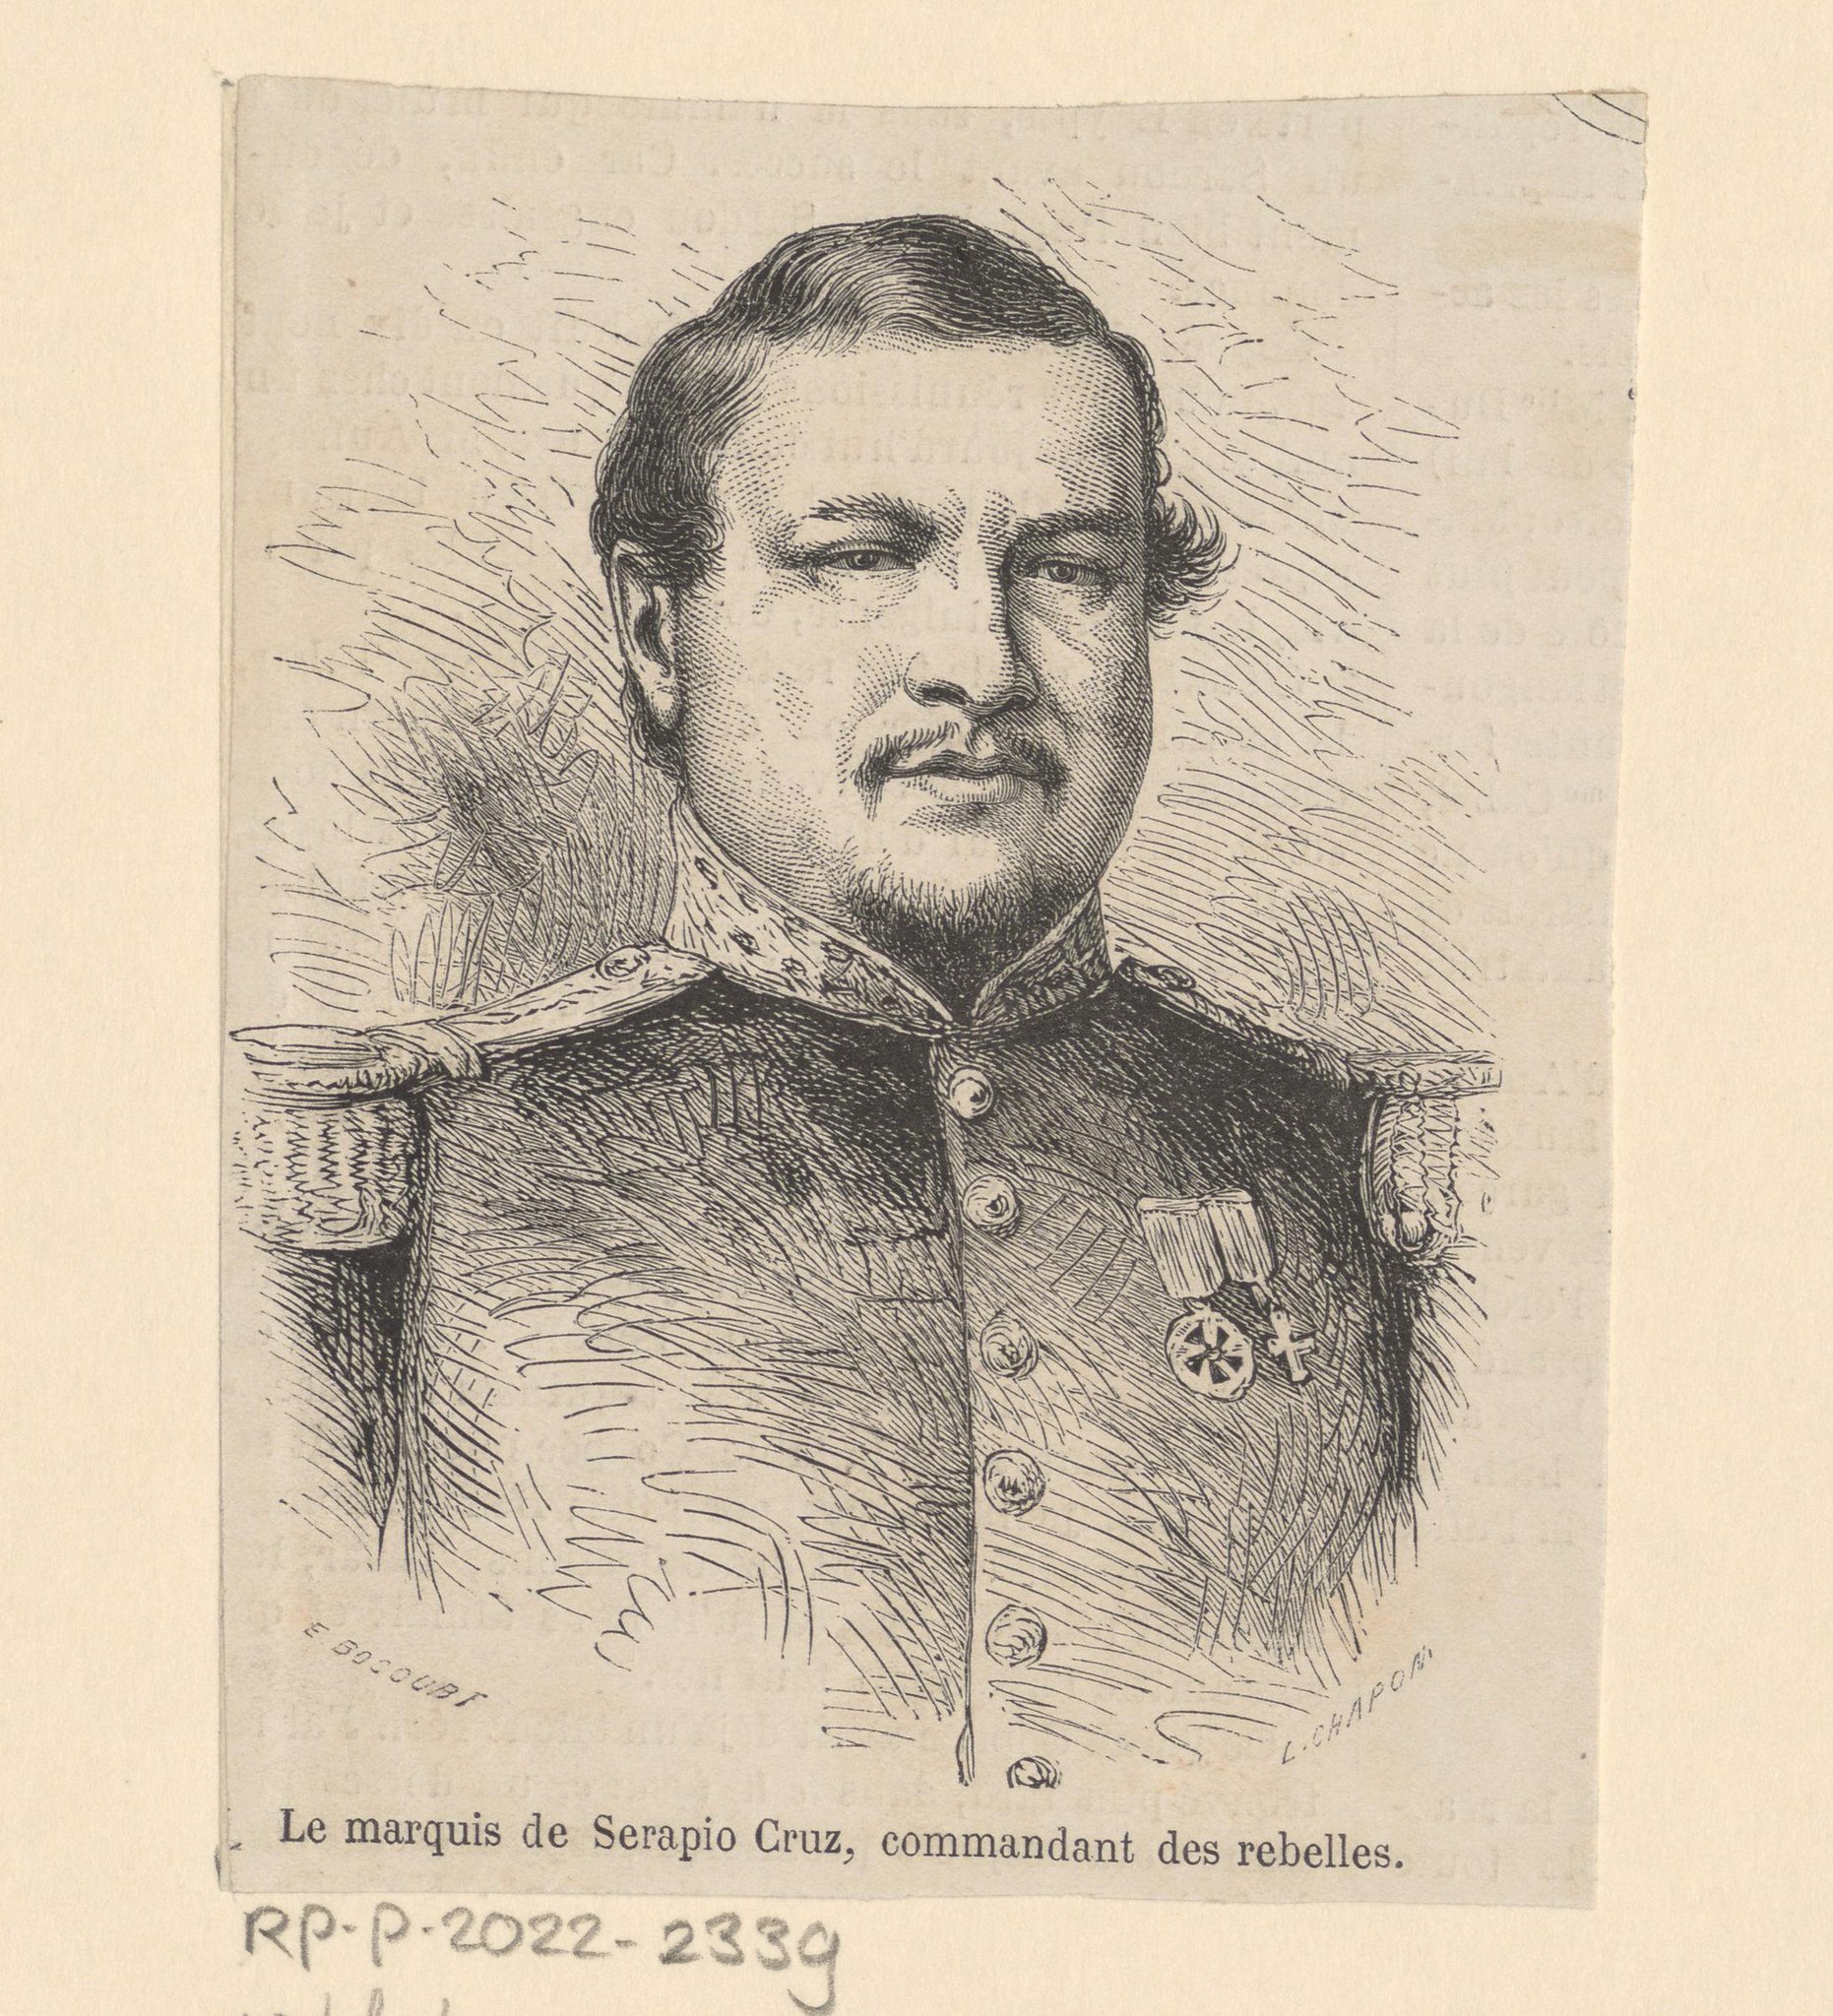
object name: print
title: Portret van Serapio Cruz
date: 1870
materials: paper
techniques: engraving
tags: historical persons, medals and other marks of military honour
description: Prent uit: Le monde illustré 681 (1870), 30 april 1870.